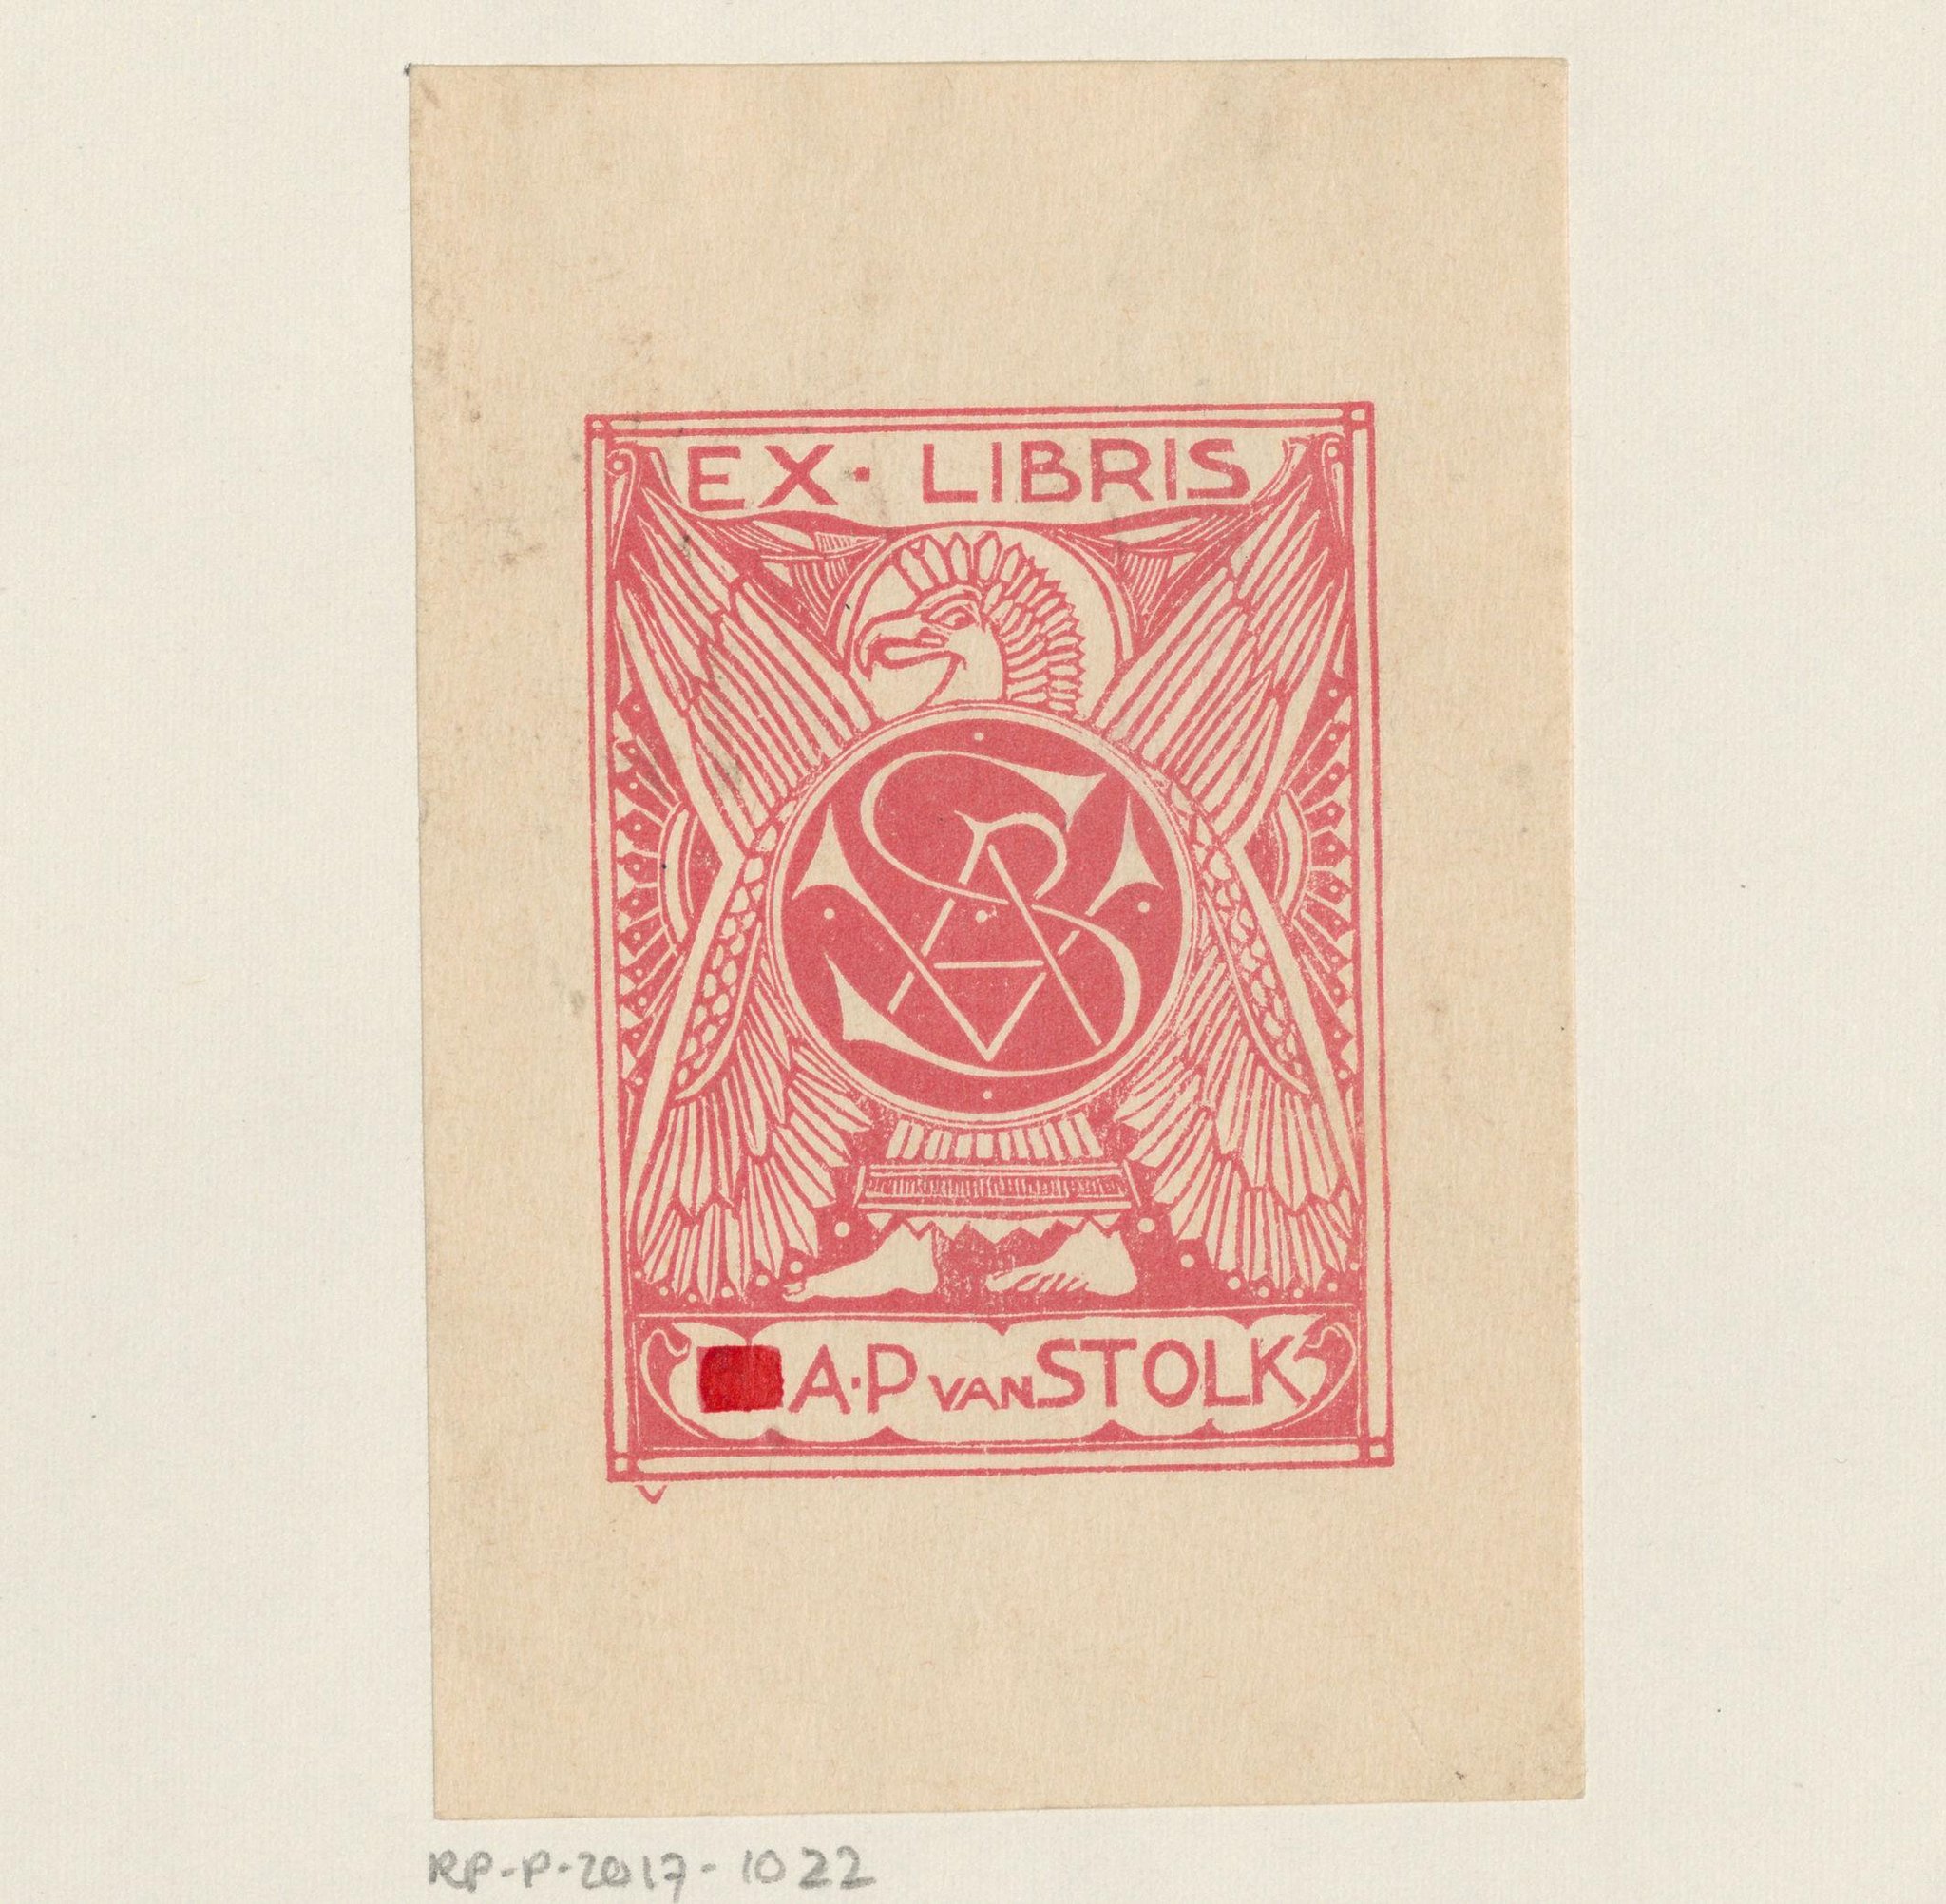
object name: bookplate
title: Ex libris van A.P. van Stolk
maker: jacobus gerardus veldheer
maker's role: draughtsman, print maker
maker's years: 1866-1954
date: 1876-1894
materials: paper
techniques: woodcut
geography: netherlands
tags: fabulous animals ~ birds, egyptian religion